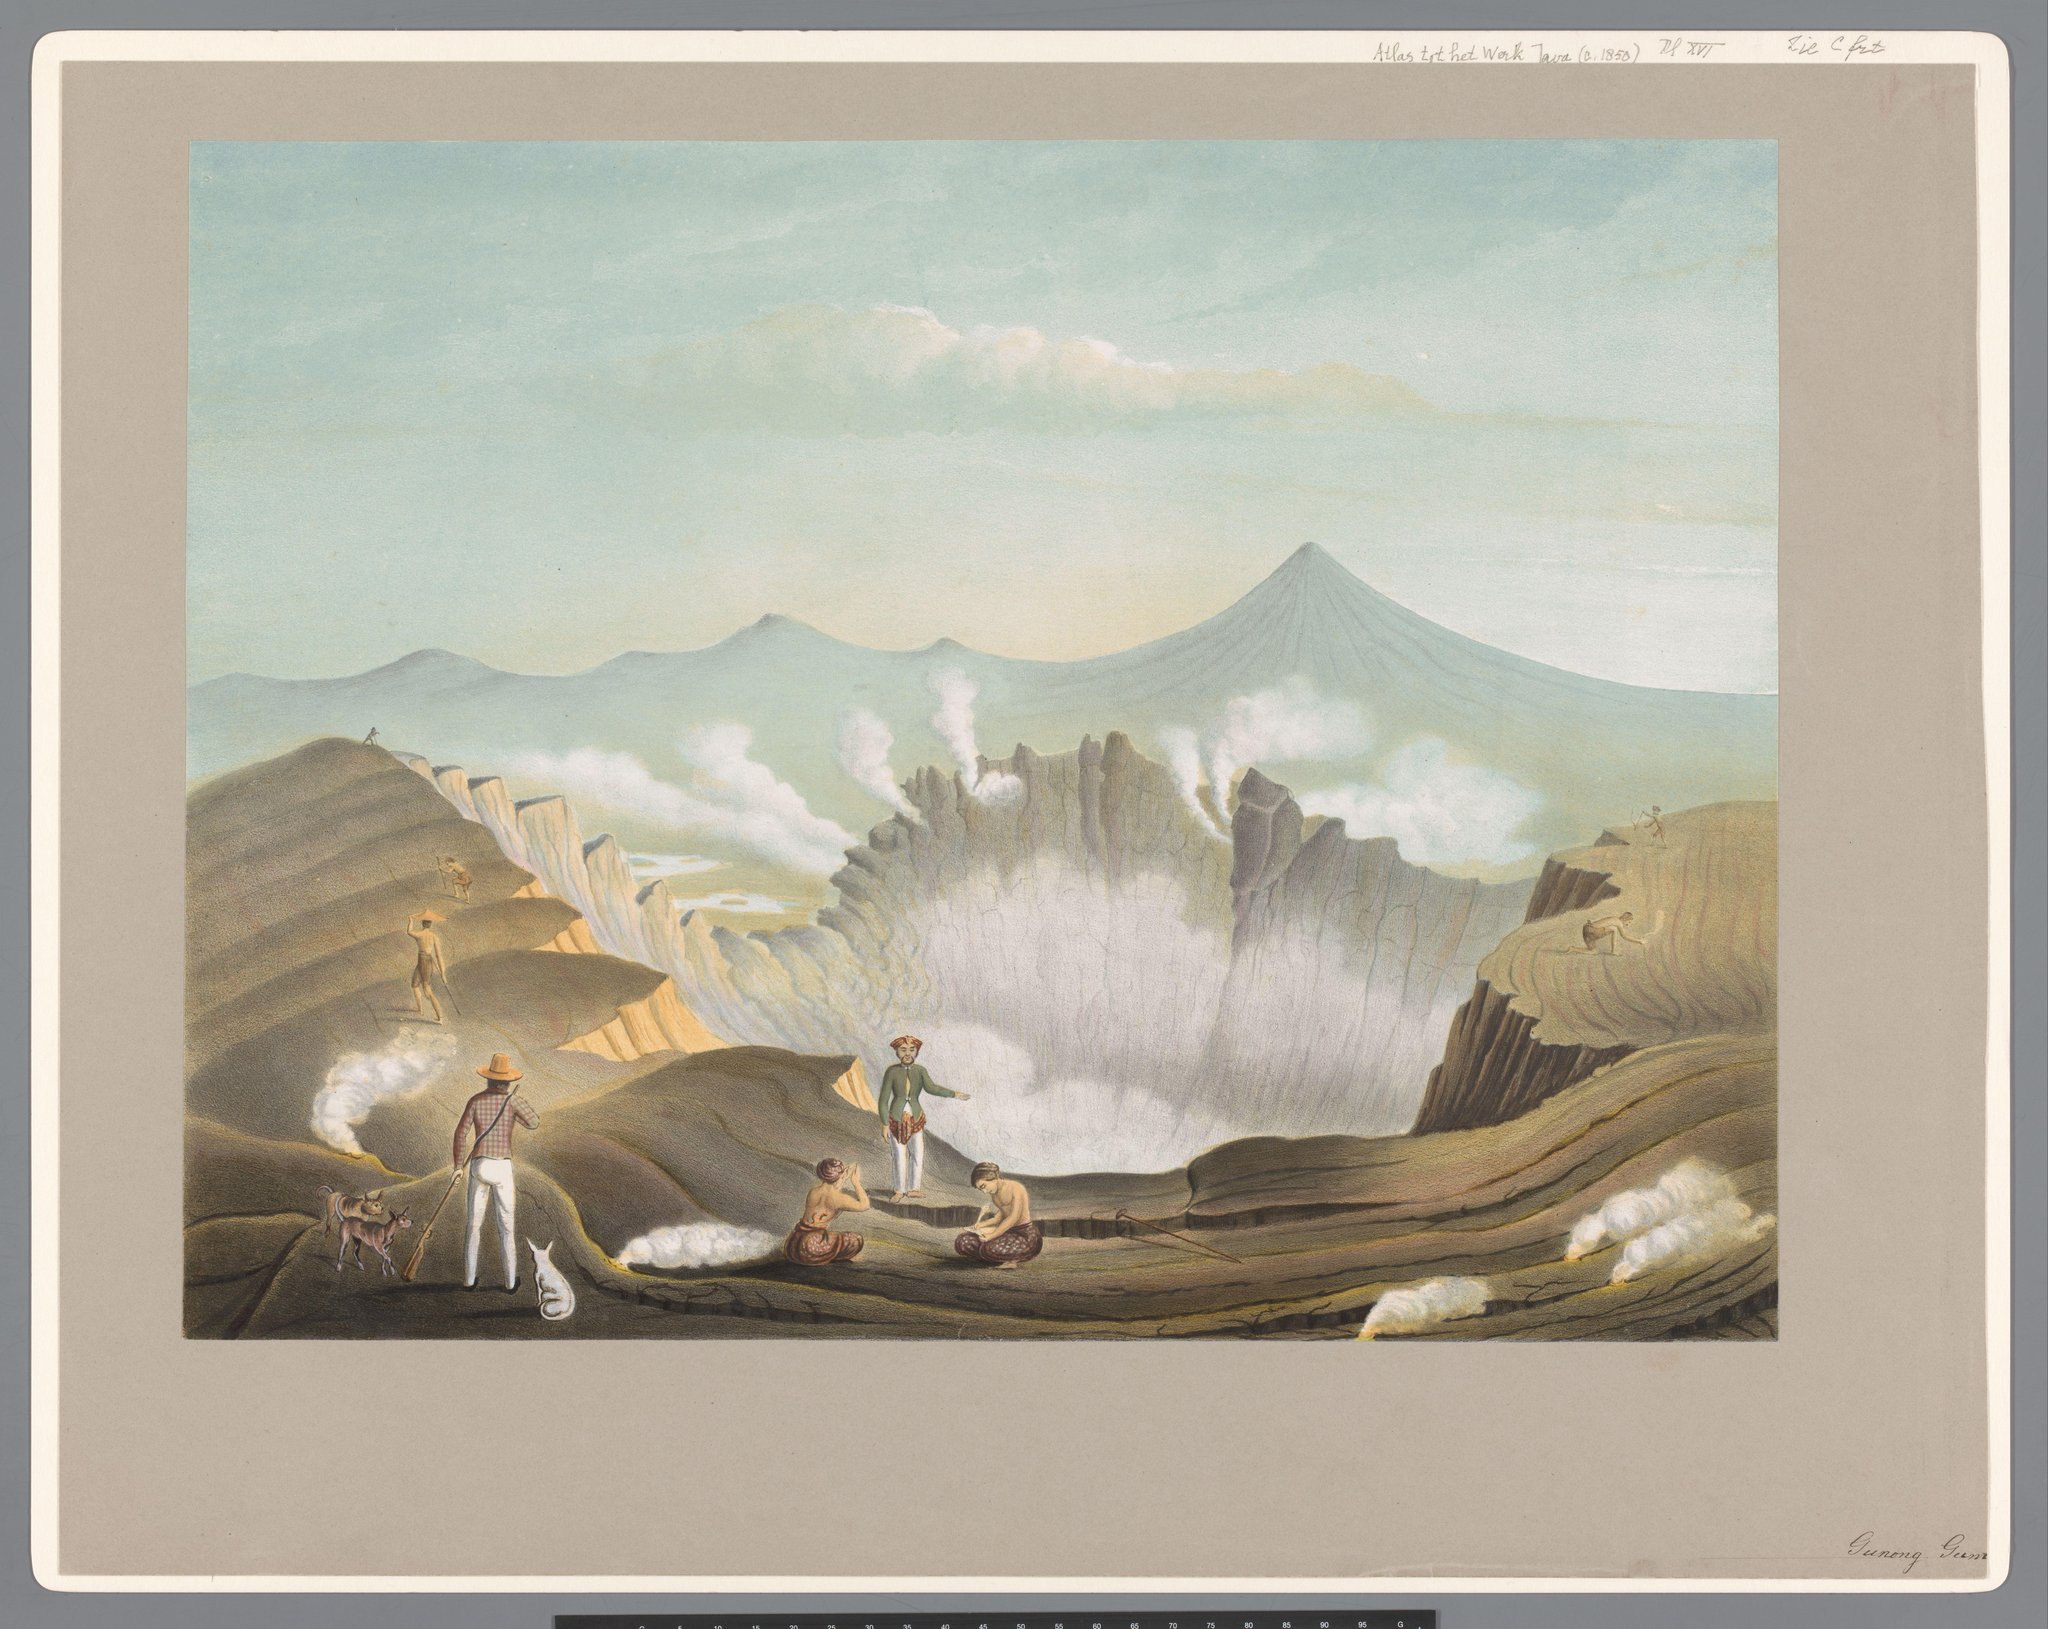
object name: print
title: Vulkaan Guntur te West-Java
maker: carl wilhelm mieling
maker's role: print maker, printer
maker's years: 1815-1903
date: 1853-1854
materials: cardboard, paper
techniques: lithograph, hand coloring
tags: volcano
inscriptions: collector's mark: Lugt 2228, collector's mark: Lugt 2228, annotation: ‘Gunung Gun’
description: Prent uit: Junghuhn, Franz Wilhelm. Atlas van platen, bevattende elf pittoreske gezigten: behoorende tot het werk Java, zijne gedaante, zijn plantentooi en inwendige bouw. Amsterdam: s.n., 1854. Of: Junghuhn, Franz Wilhelm. Elf Landschafts-Ansichten von Java. Leipzig: Arnold, 1853.